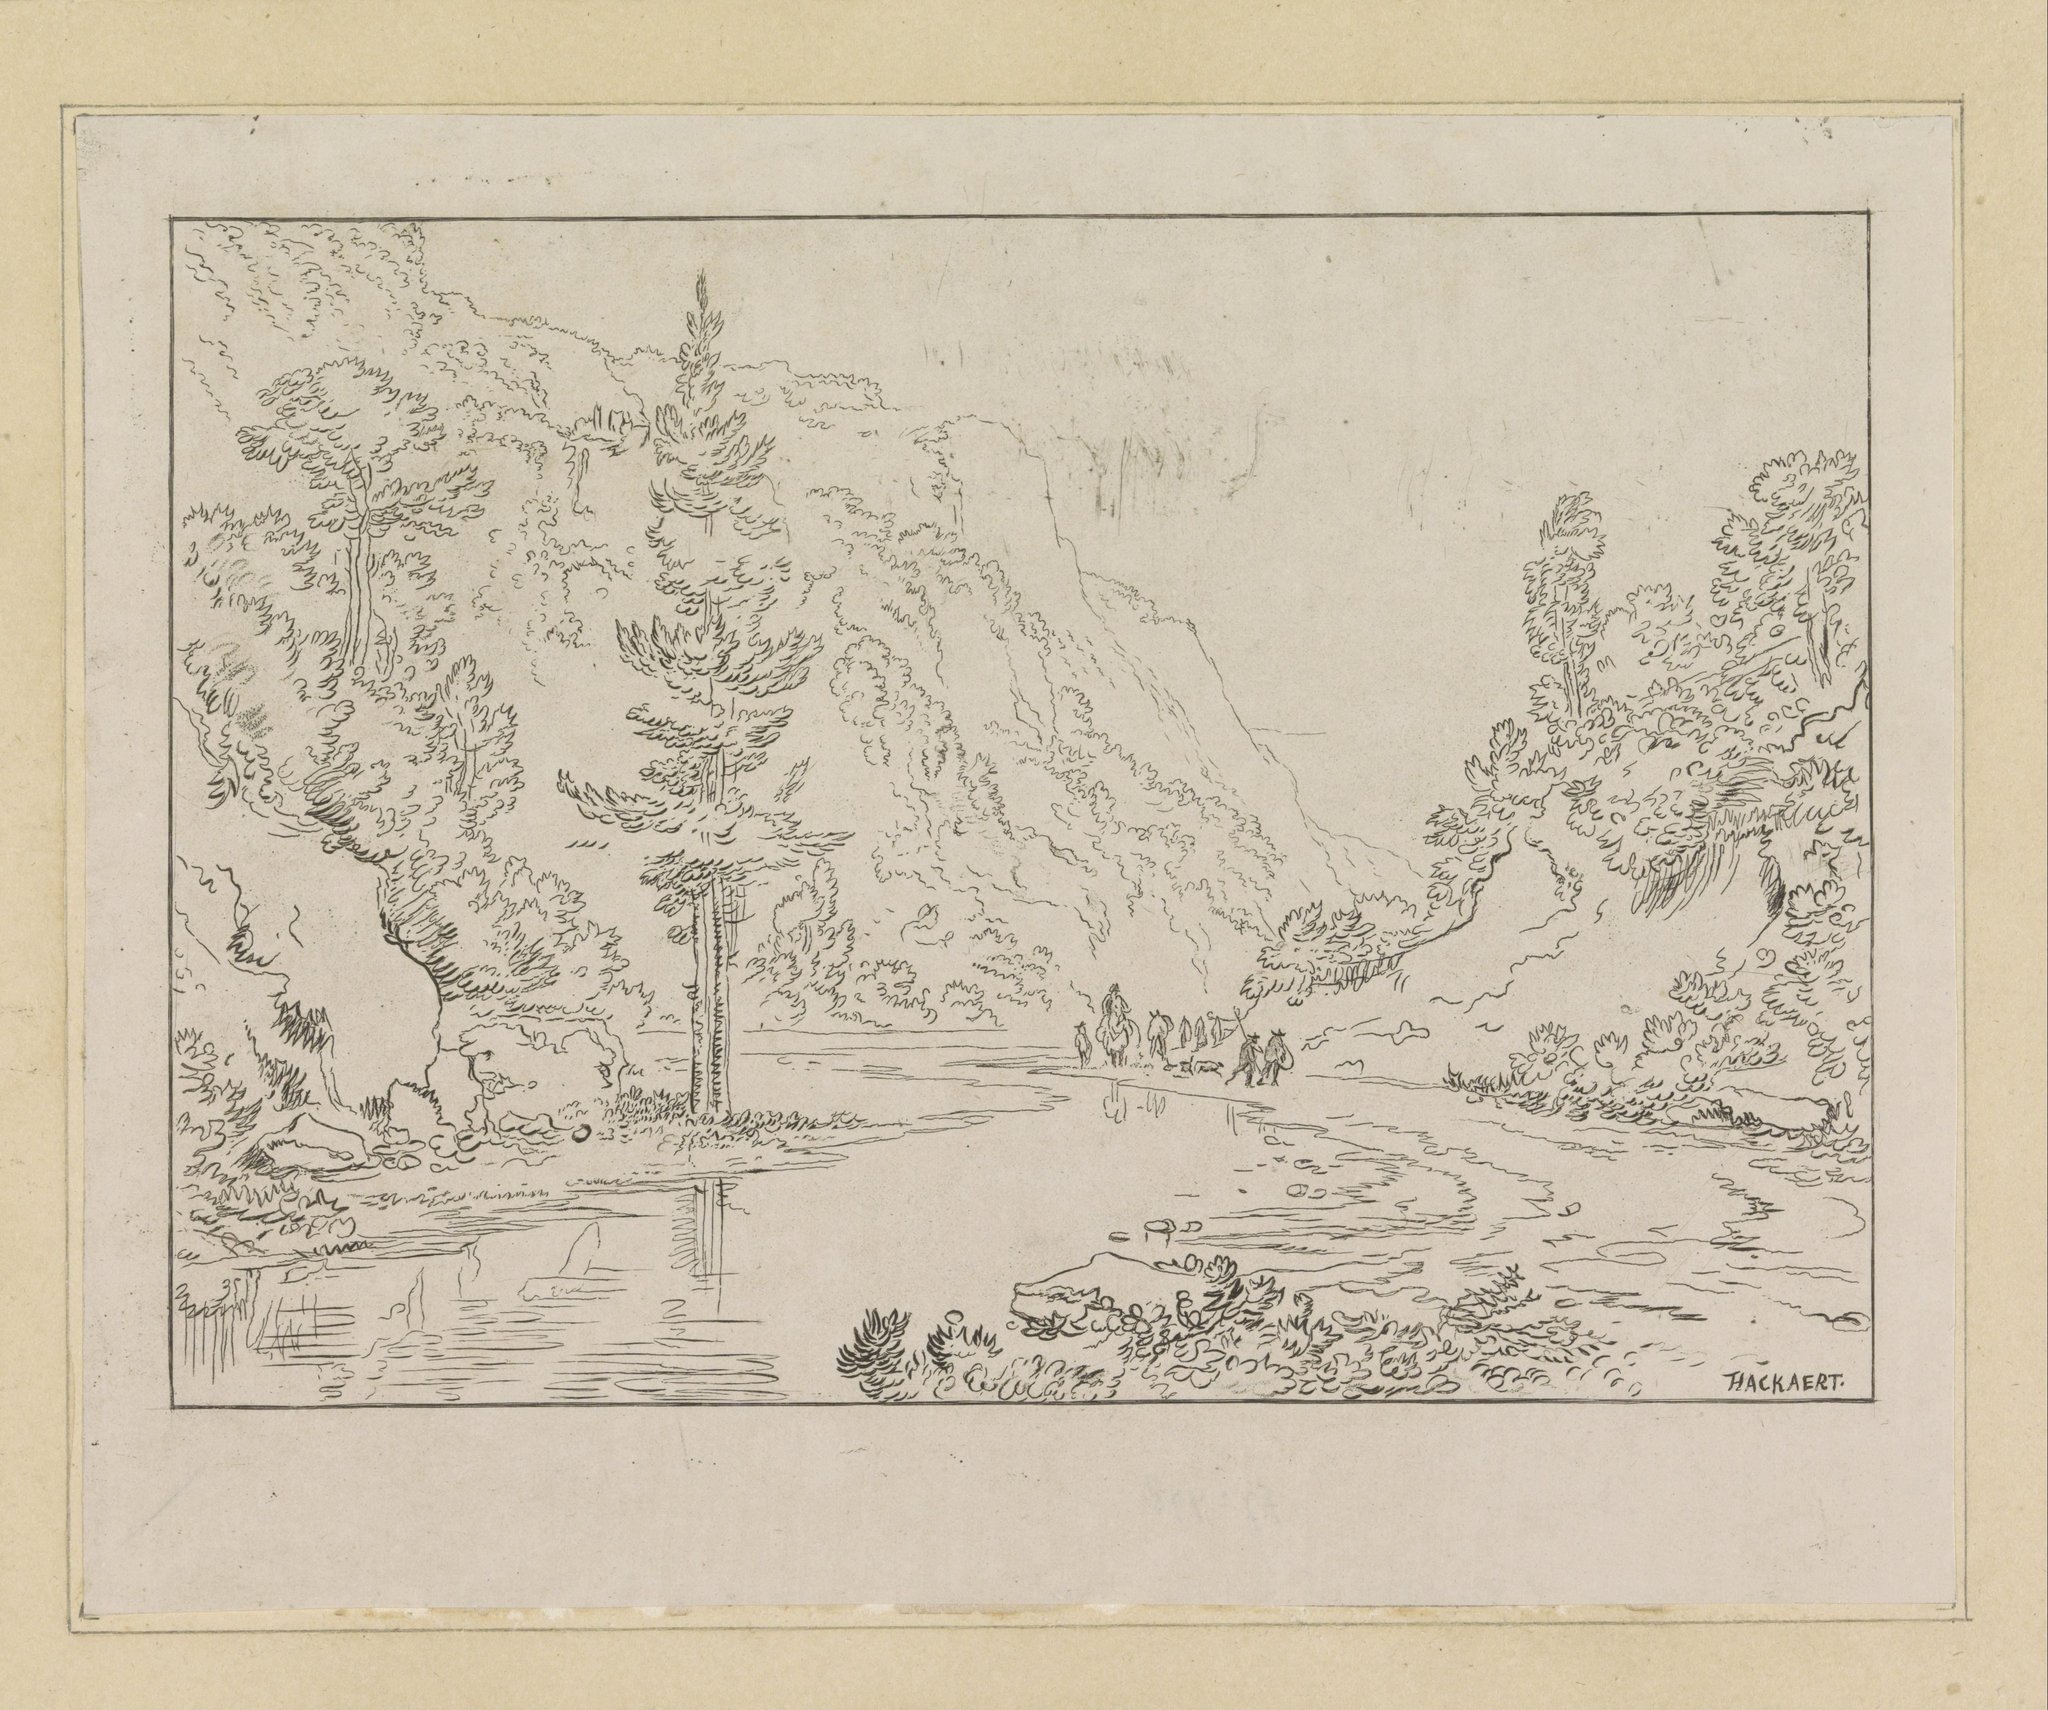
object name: print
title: Berglandschap met herders op een rivieroever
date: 1795-1821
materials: paper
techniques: etching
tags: river, mountains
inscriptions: collector's mark: Lugt 2228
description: De voltooide prent werd opgenomen in: Collection d'imitations de dessins d'après les principaux maîtres hollandais et flamands, Londen, C. Josi, 1821.